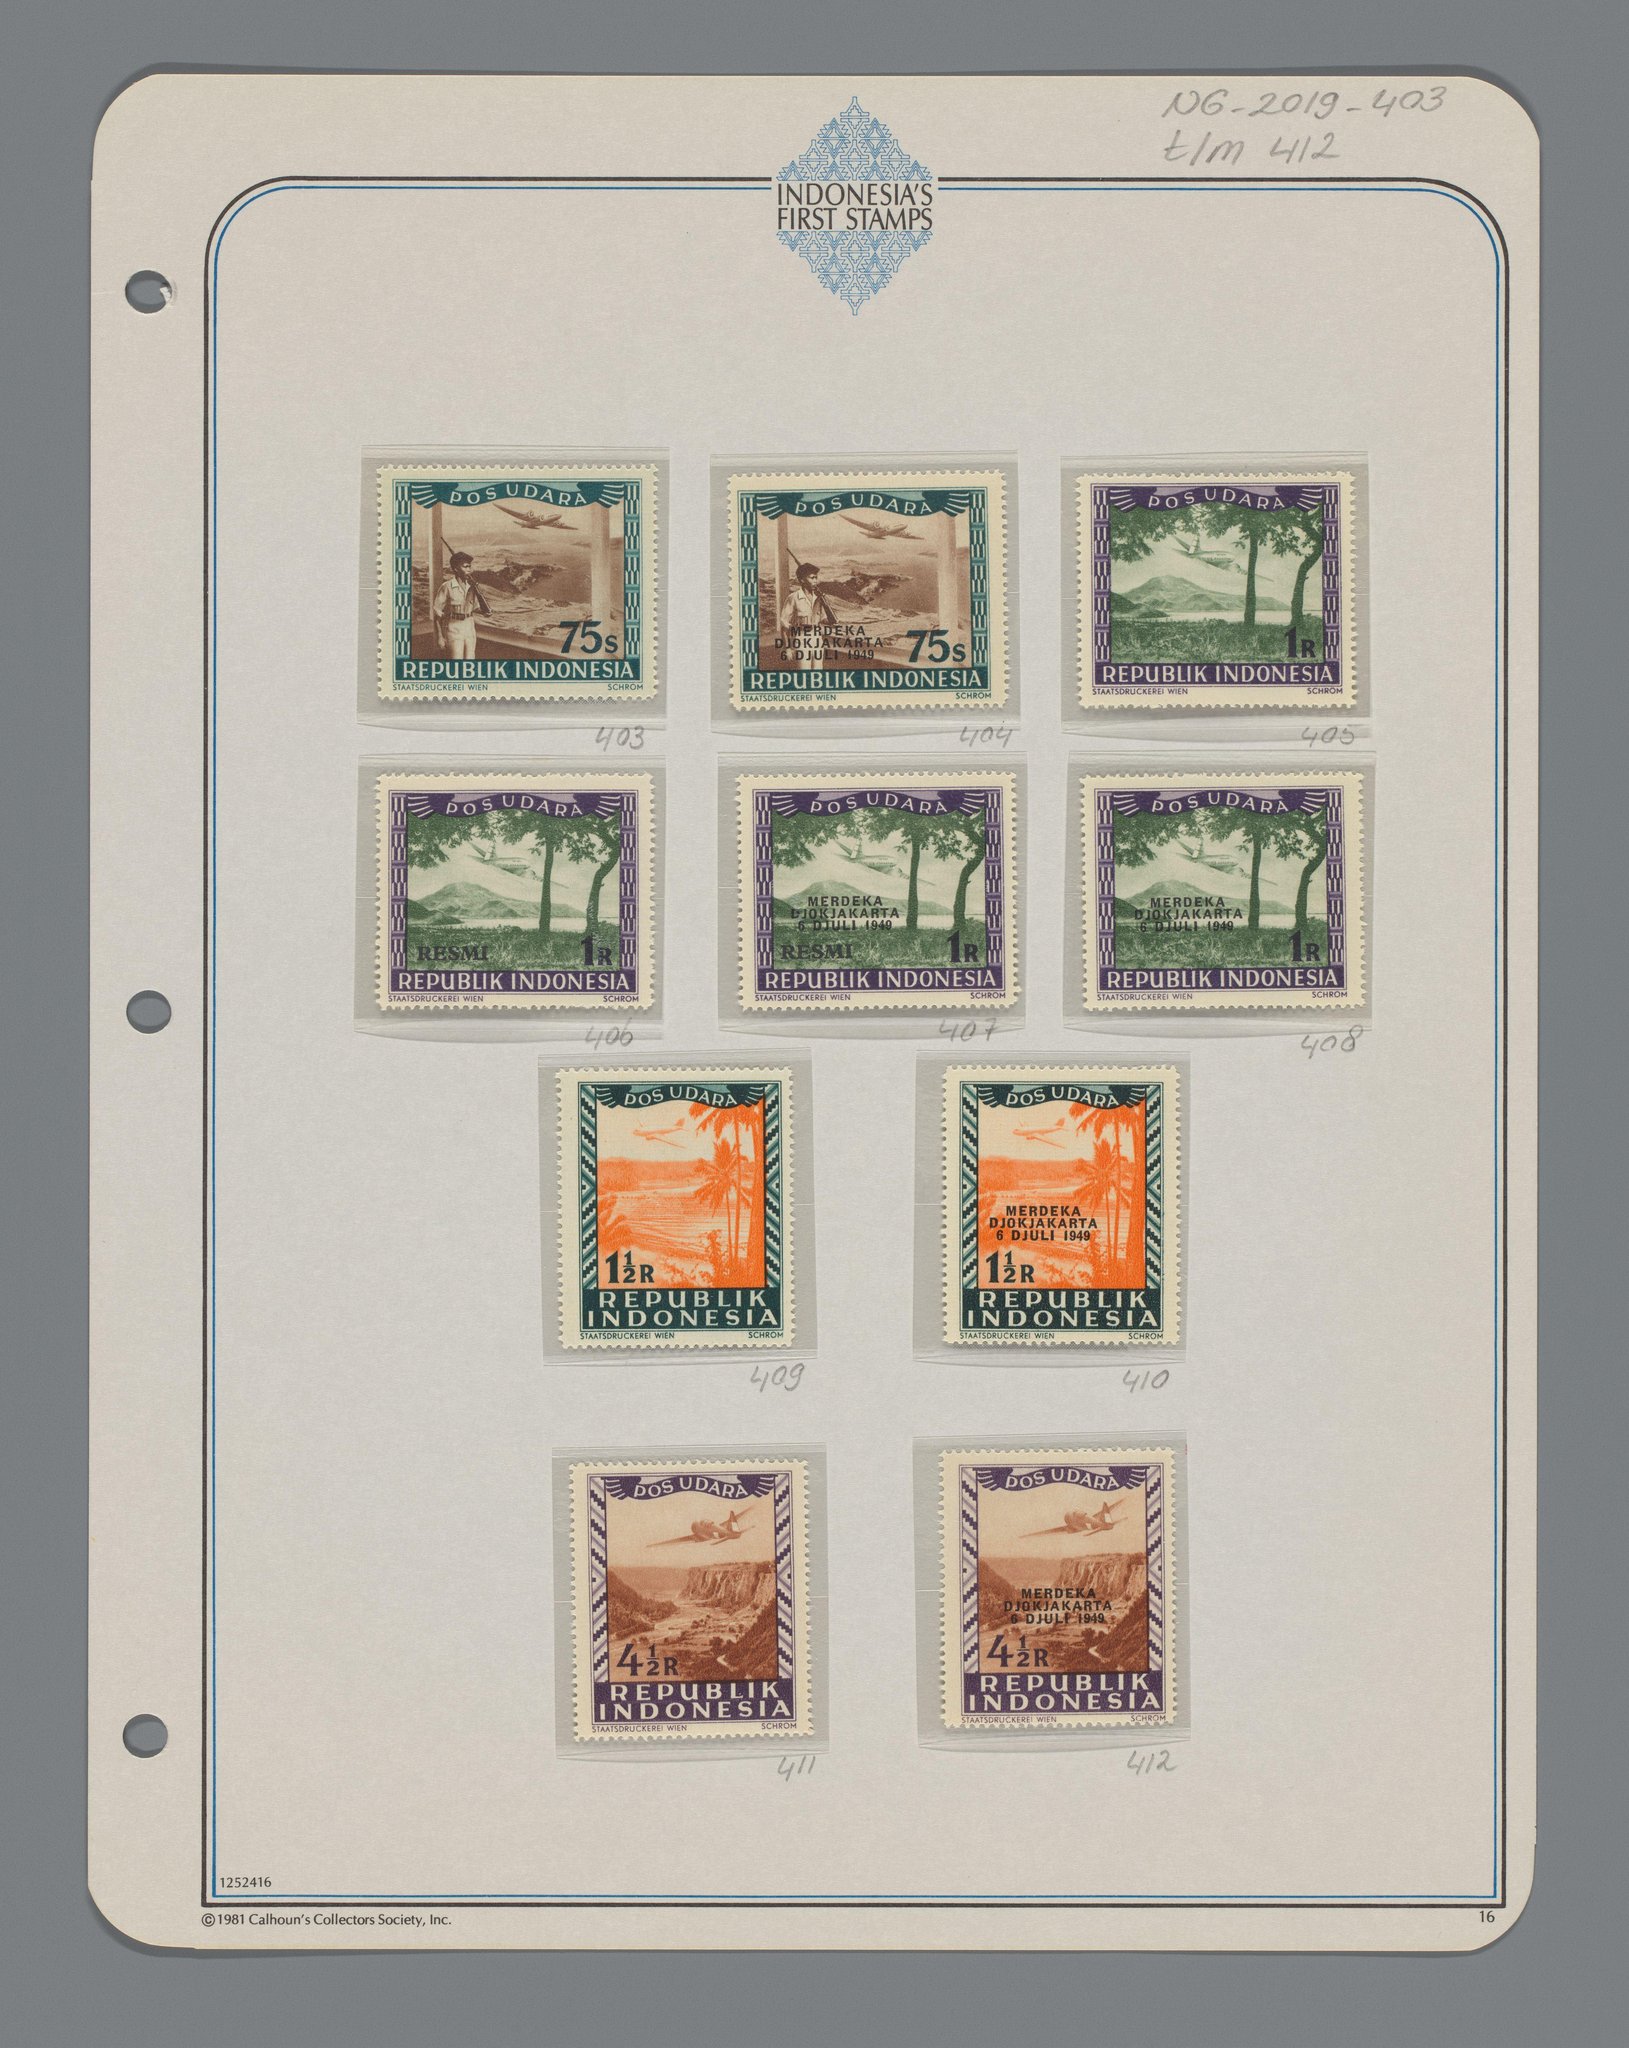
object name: postage stamp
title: Postzegel Republik Indonesia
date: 1949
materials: paper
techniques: photoaquatint, engraving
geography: philadelphia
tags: indonesia